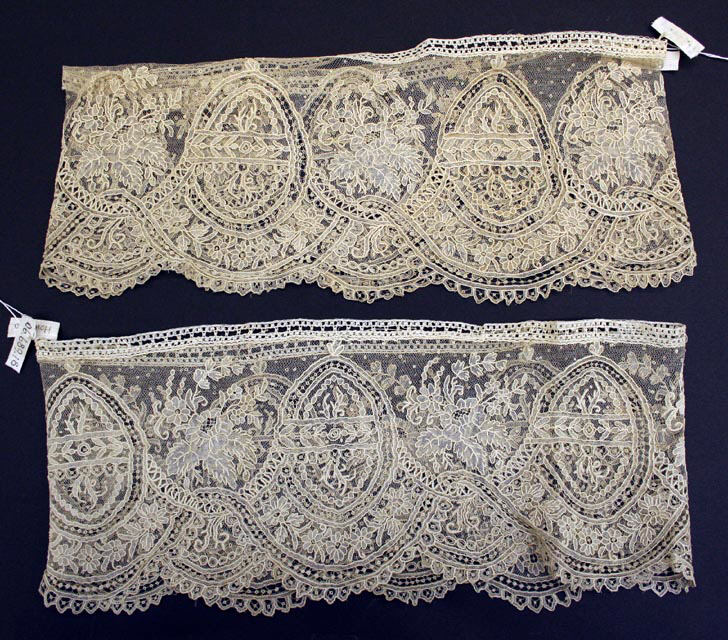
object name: cuff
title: Cuffs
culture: belgian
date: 1801-1900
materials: silk